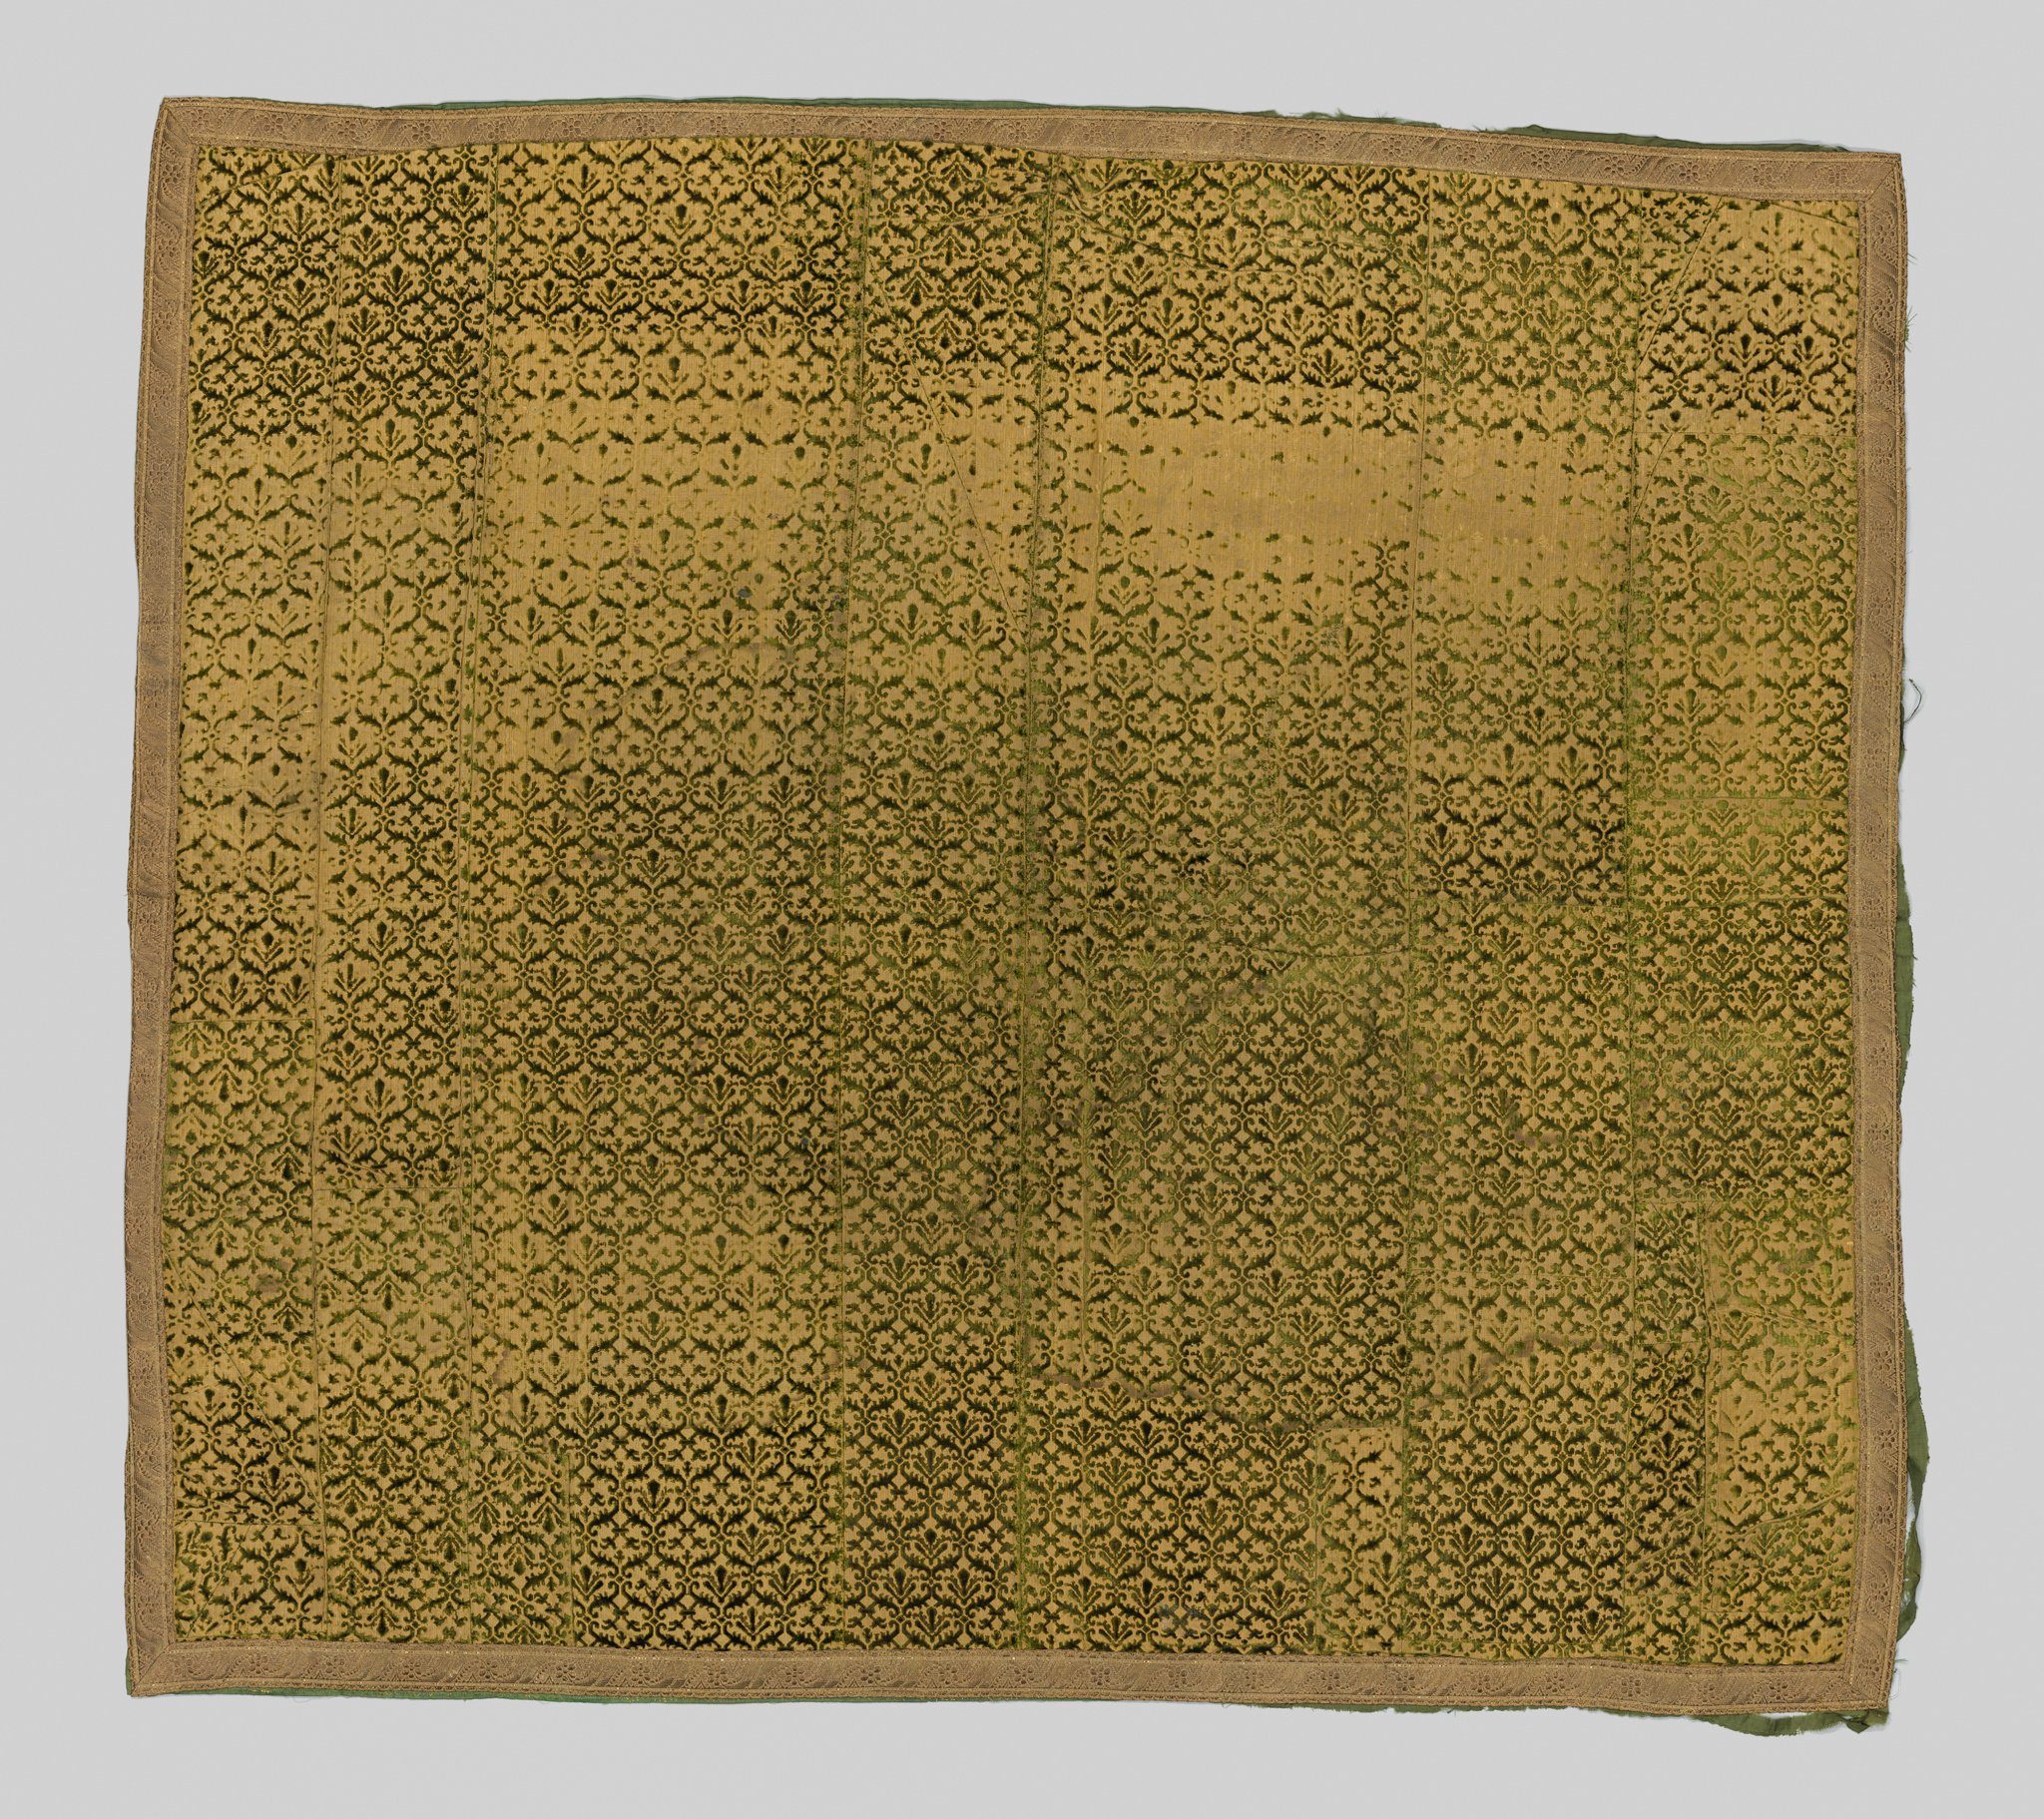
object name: textile cover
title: Cover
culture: italian or spanish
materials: cotton, metal, silk